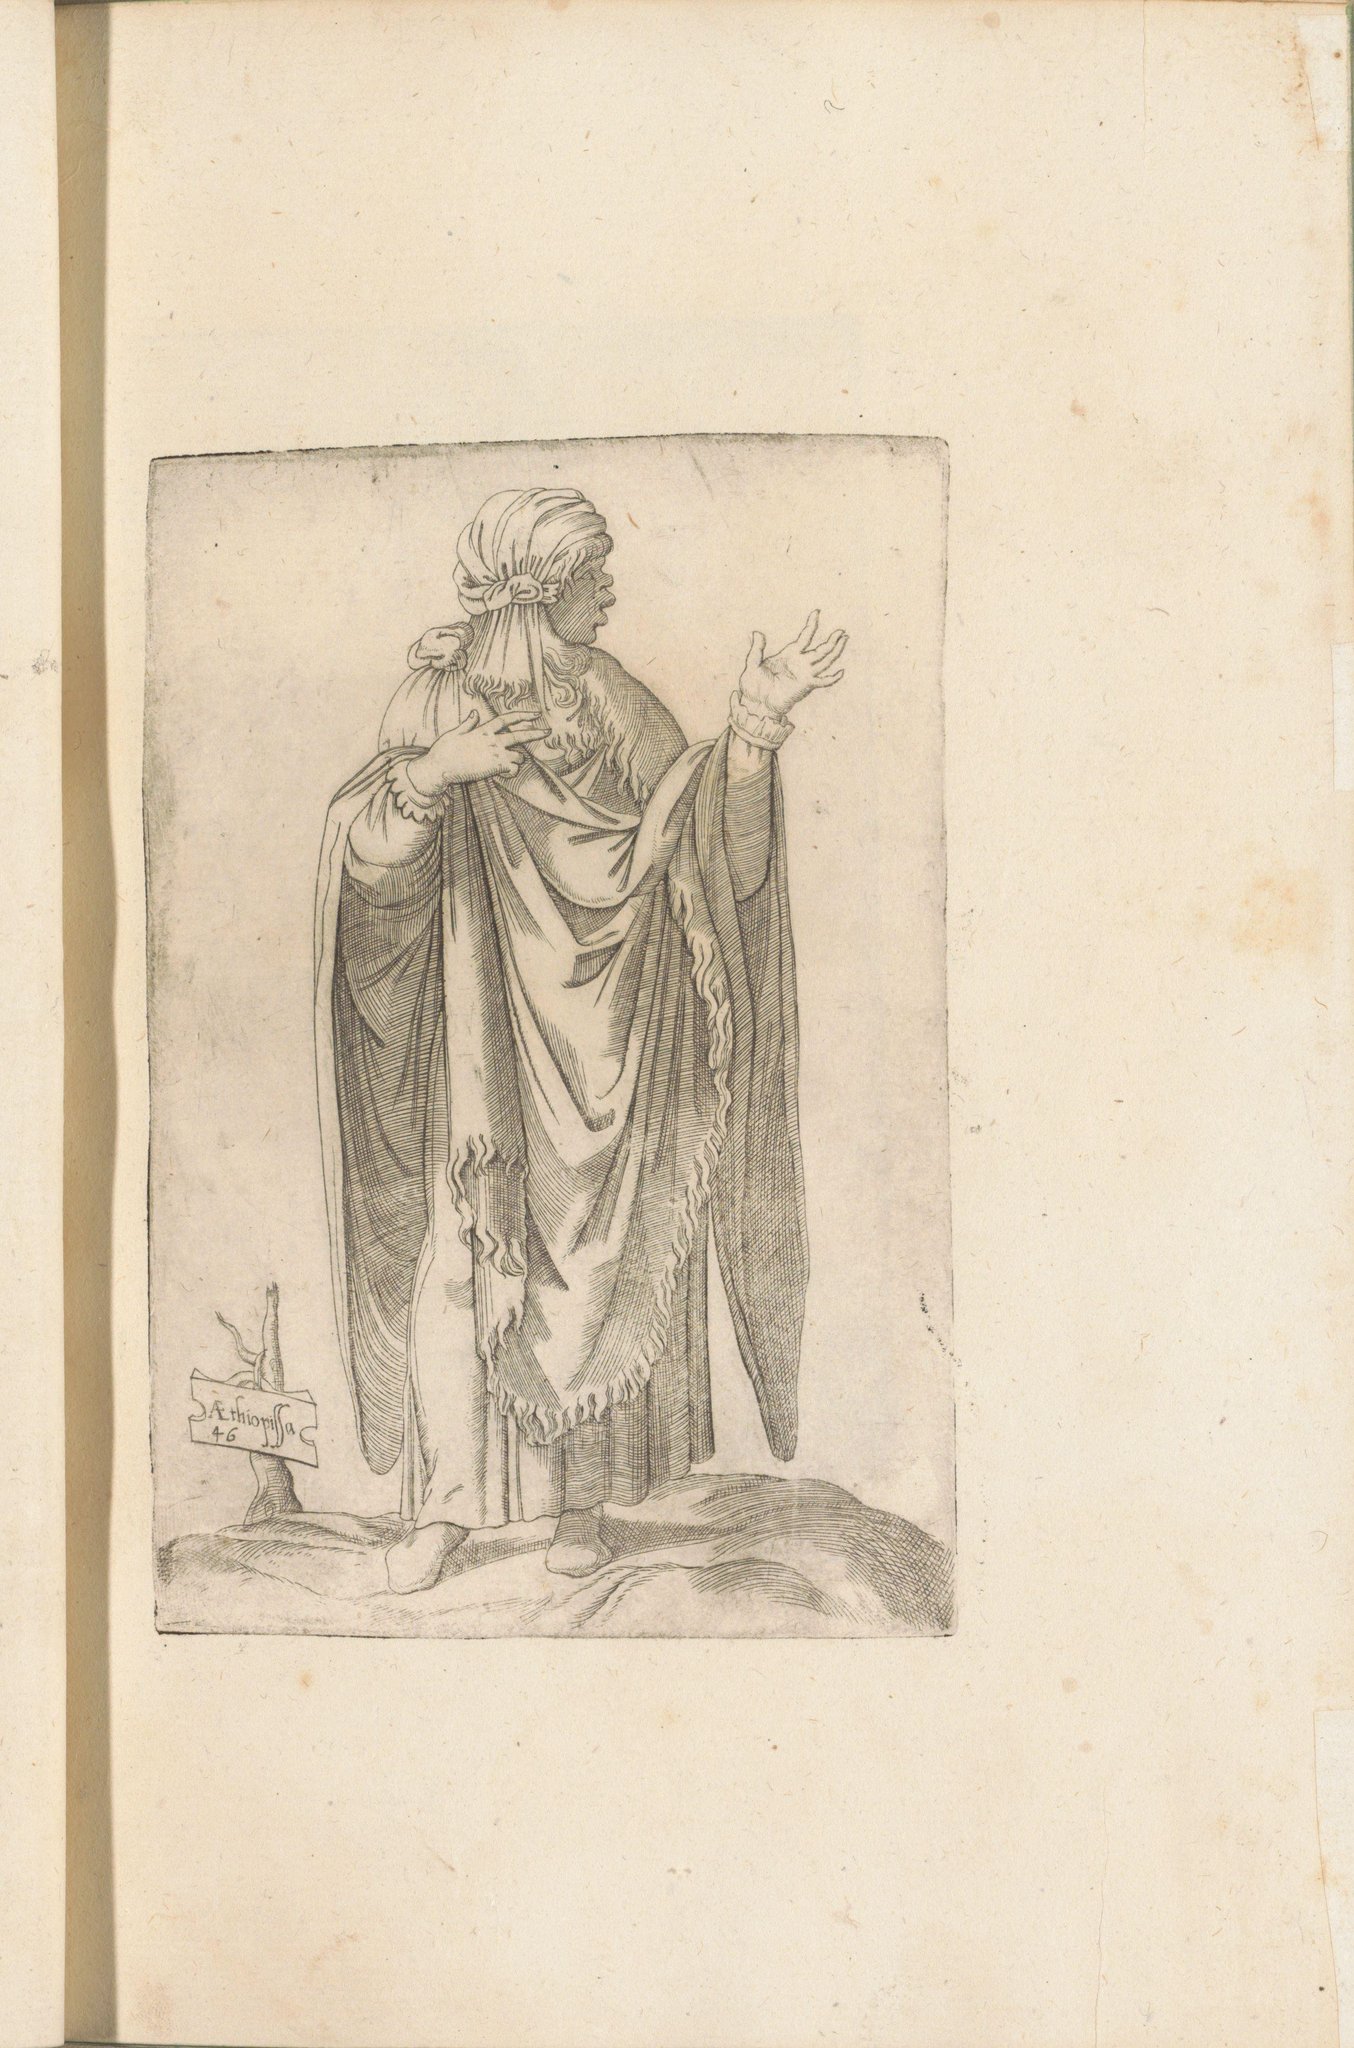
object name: costume print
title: Aethiopissa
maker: ferando bertelli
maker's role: print maker, publisher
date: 1569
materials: paper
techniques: engraving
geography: venice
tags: africans (+ costume), fashion plates, head-gear: turban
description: Vrouw uit Ethiopië, in wijde mantel, tulband op het hoofd. Onderdeel van het kostuumboek getiteld 'Omnium fere gentium nostrae aetatis habitus, nunquam ante hac aediti', Venetië 1569. Heruitgave uit 1569 van de eerste editie uit 1563.